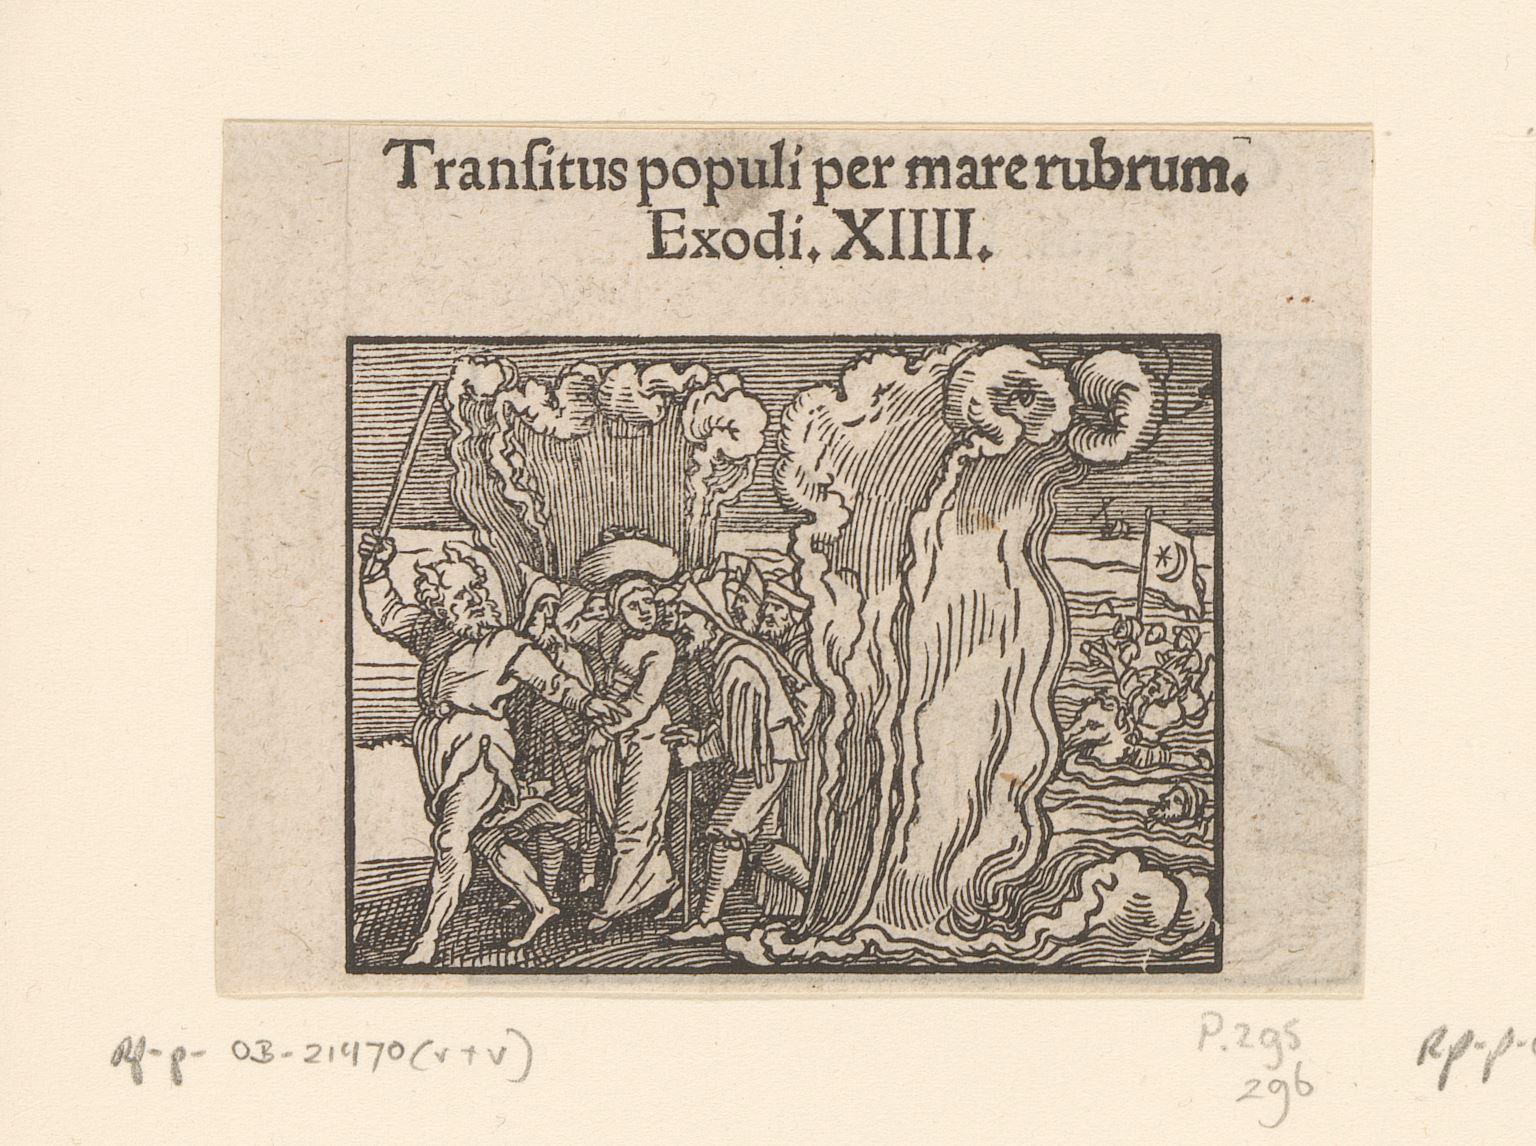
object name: book illustration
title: Doortocht door de Rode Zee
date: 1530-1533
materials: paper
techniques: letterpress printing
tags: passage through the red sea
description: Prent afkomstig uit: Biblicae historiae. Frankfurt am Main: Egenloph, 1539.